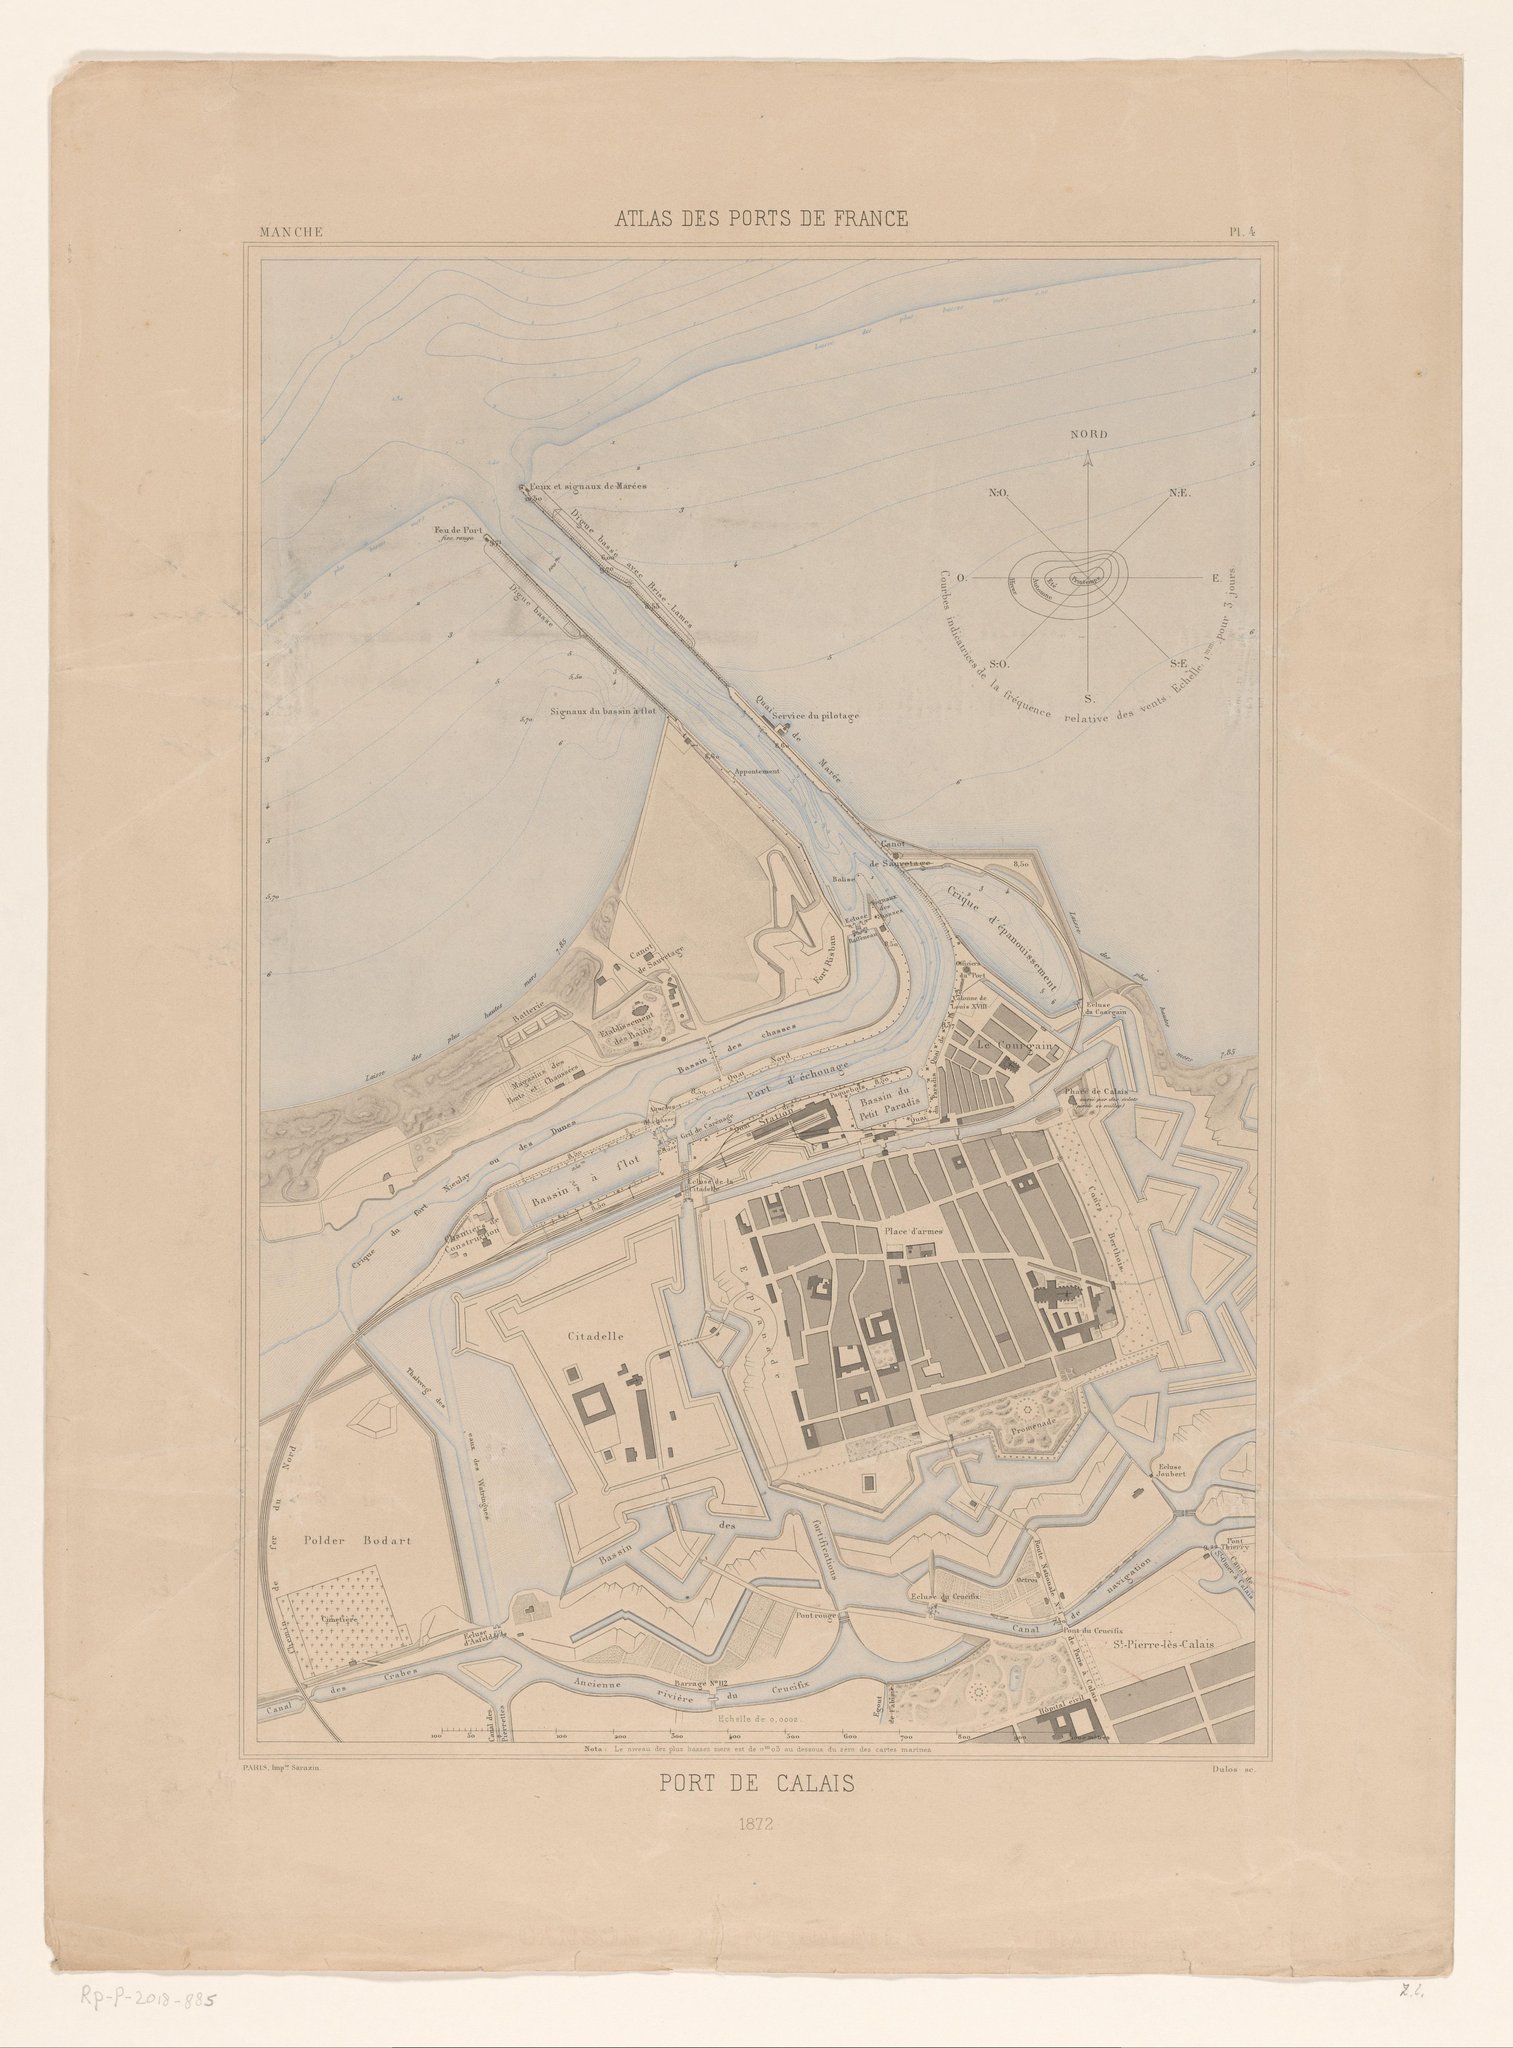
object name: area plan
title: Port de Calais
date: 1874-1899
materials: paper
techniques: engraving, etching, hand coloring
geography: paris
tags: harbour, maps of cities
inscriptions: collector's mark: Lugt 2228